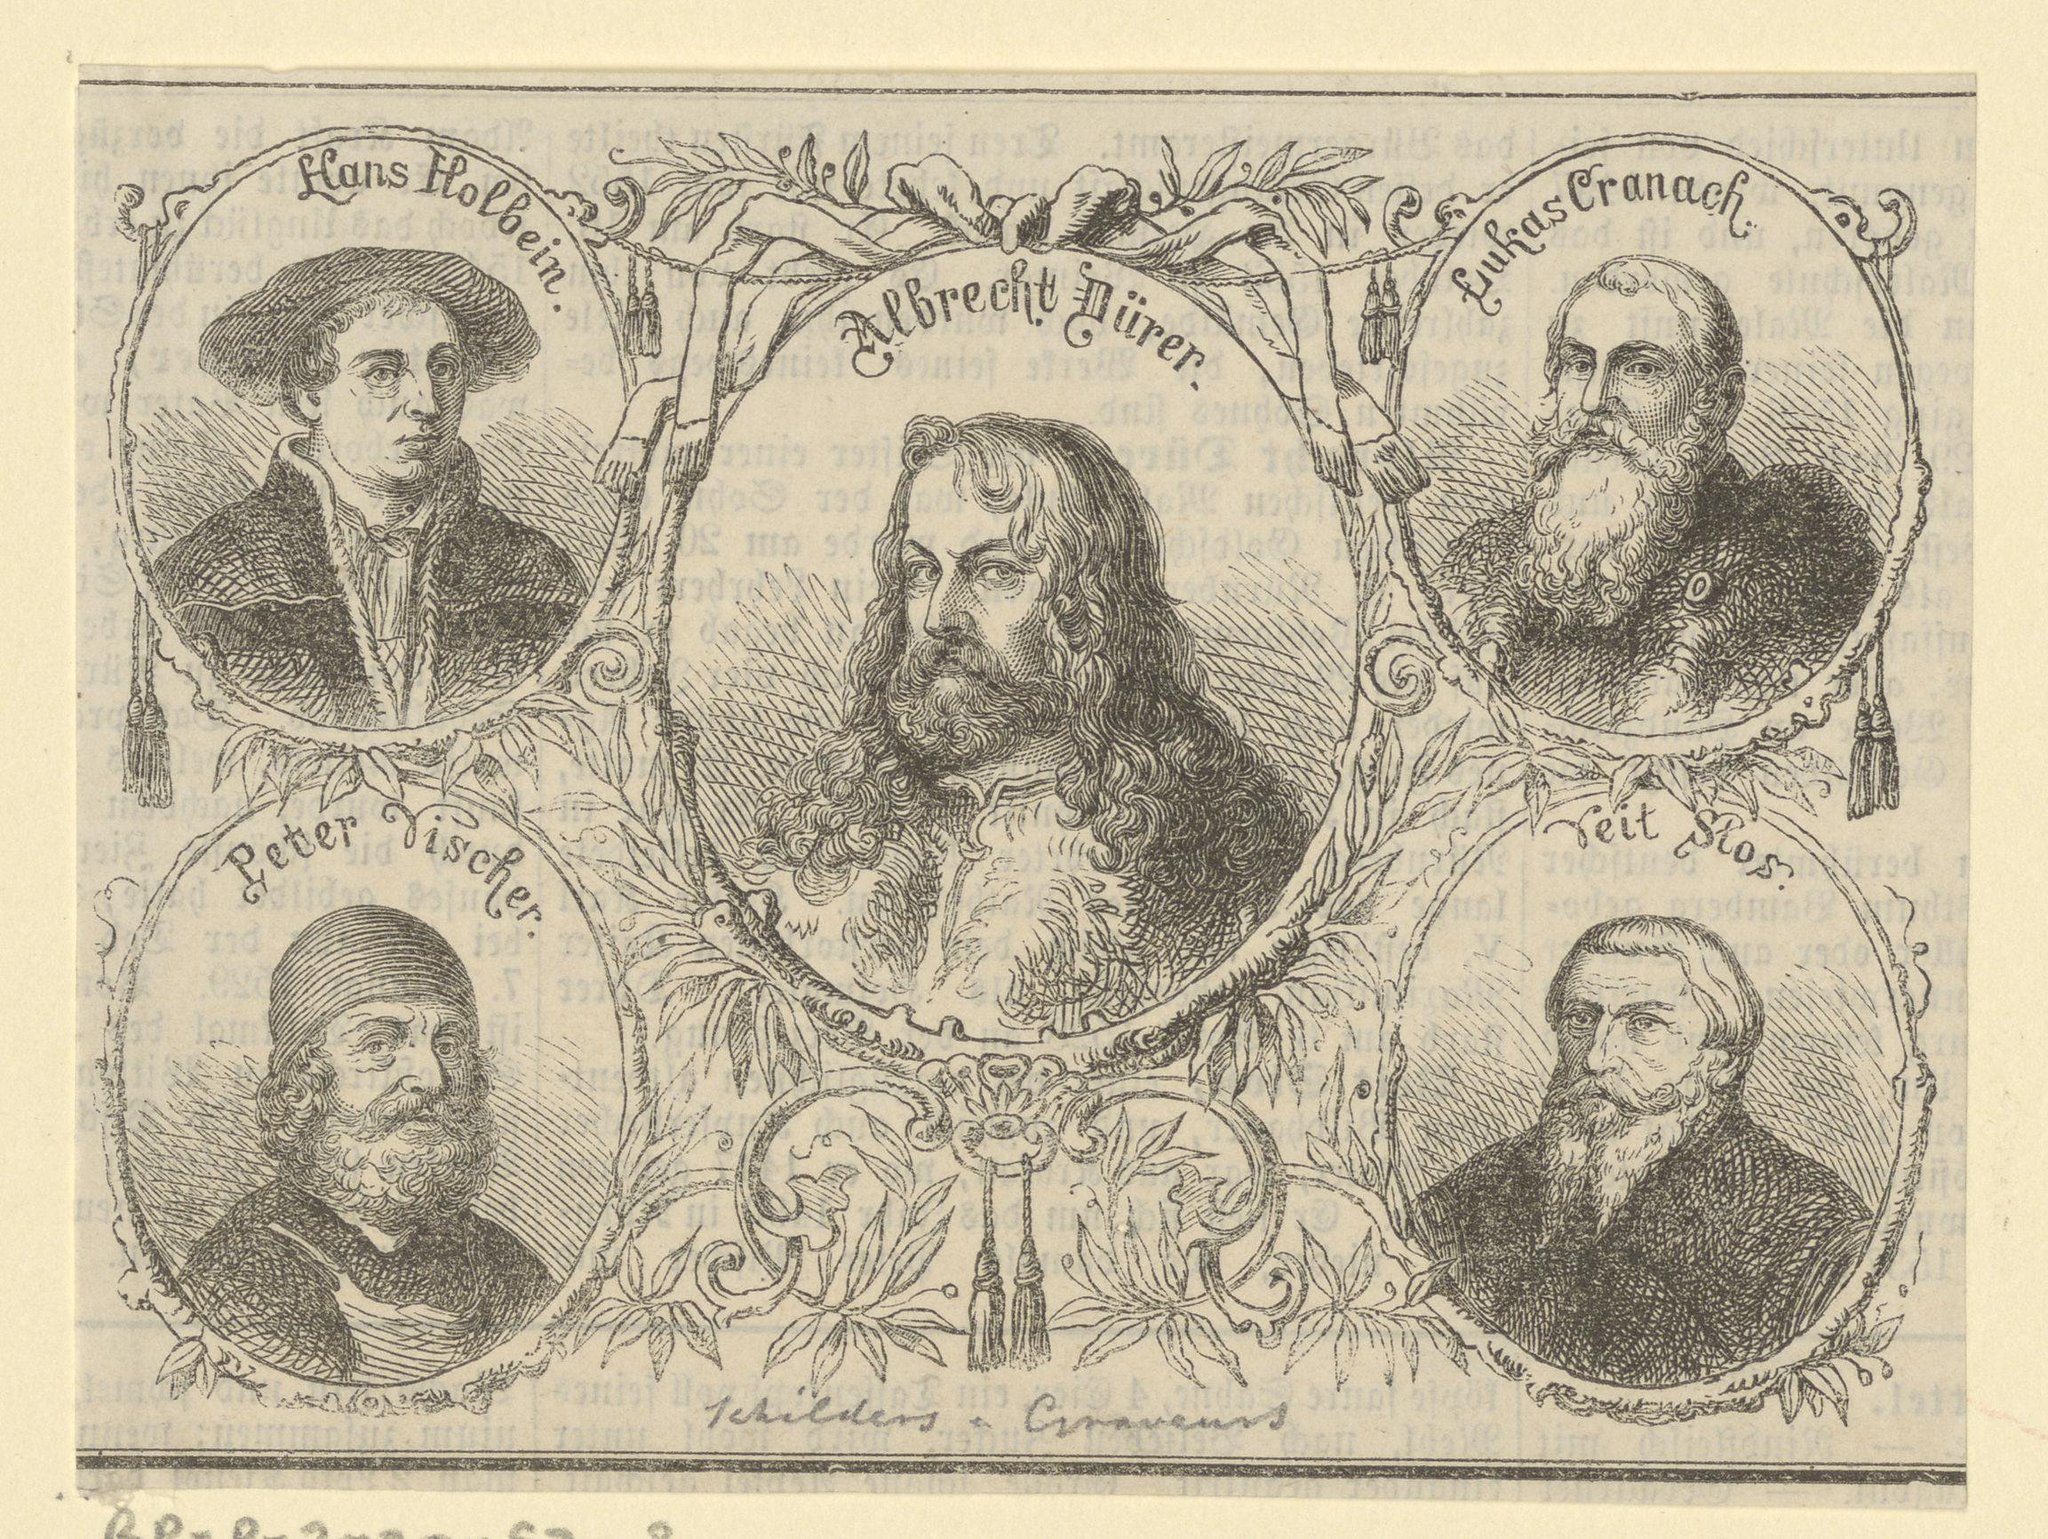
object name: print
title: Portret van Hans Holbein II, Peter Vischer, Albrecht Dürer, Lucas Cranach I en Veit Stoss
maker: Anonymous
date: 1867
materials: paper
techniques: letterpress printing, engraving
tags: augsburg, painter, draughtsman, hans holbein (ii), print maker, lucas cranach (i), sculptor, peter vischer, albrecht dürer, portrait, self-portrait of sculptor, historical persons, portrait, self-portrait of painter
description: Vijf portretten in ovalen met het portret van Dürer in het midden.